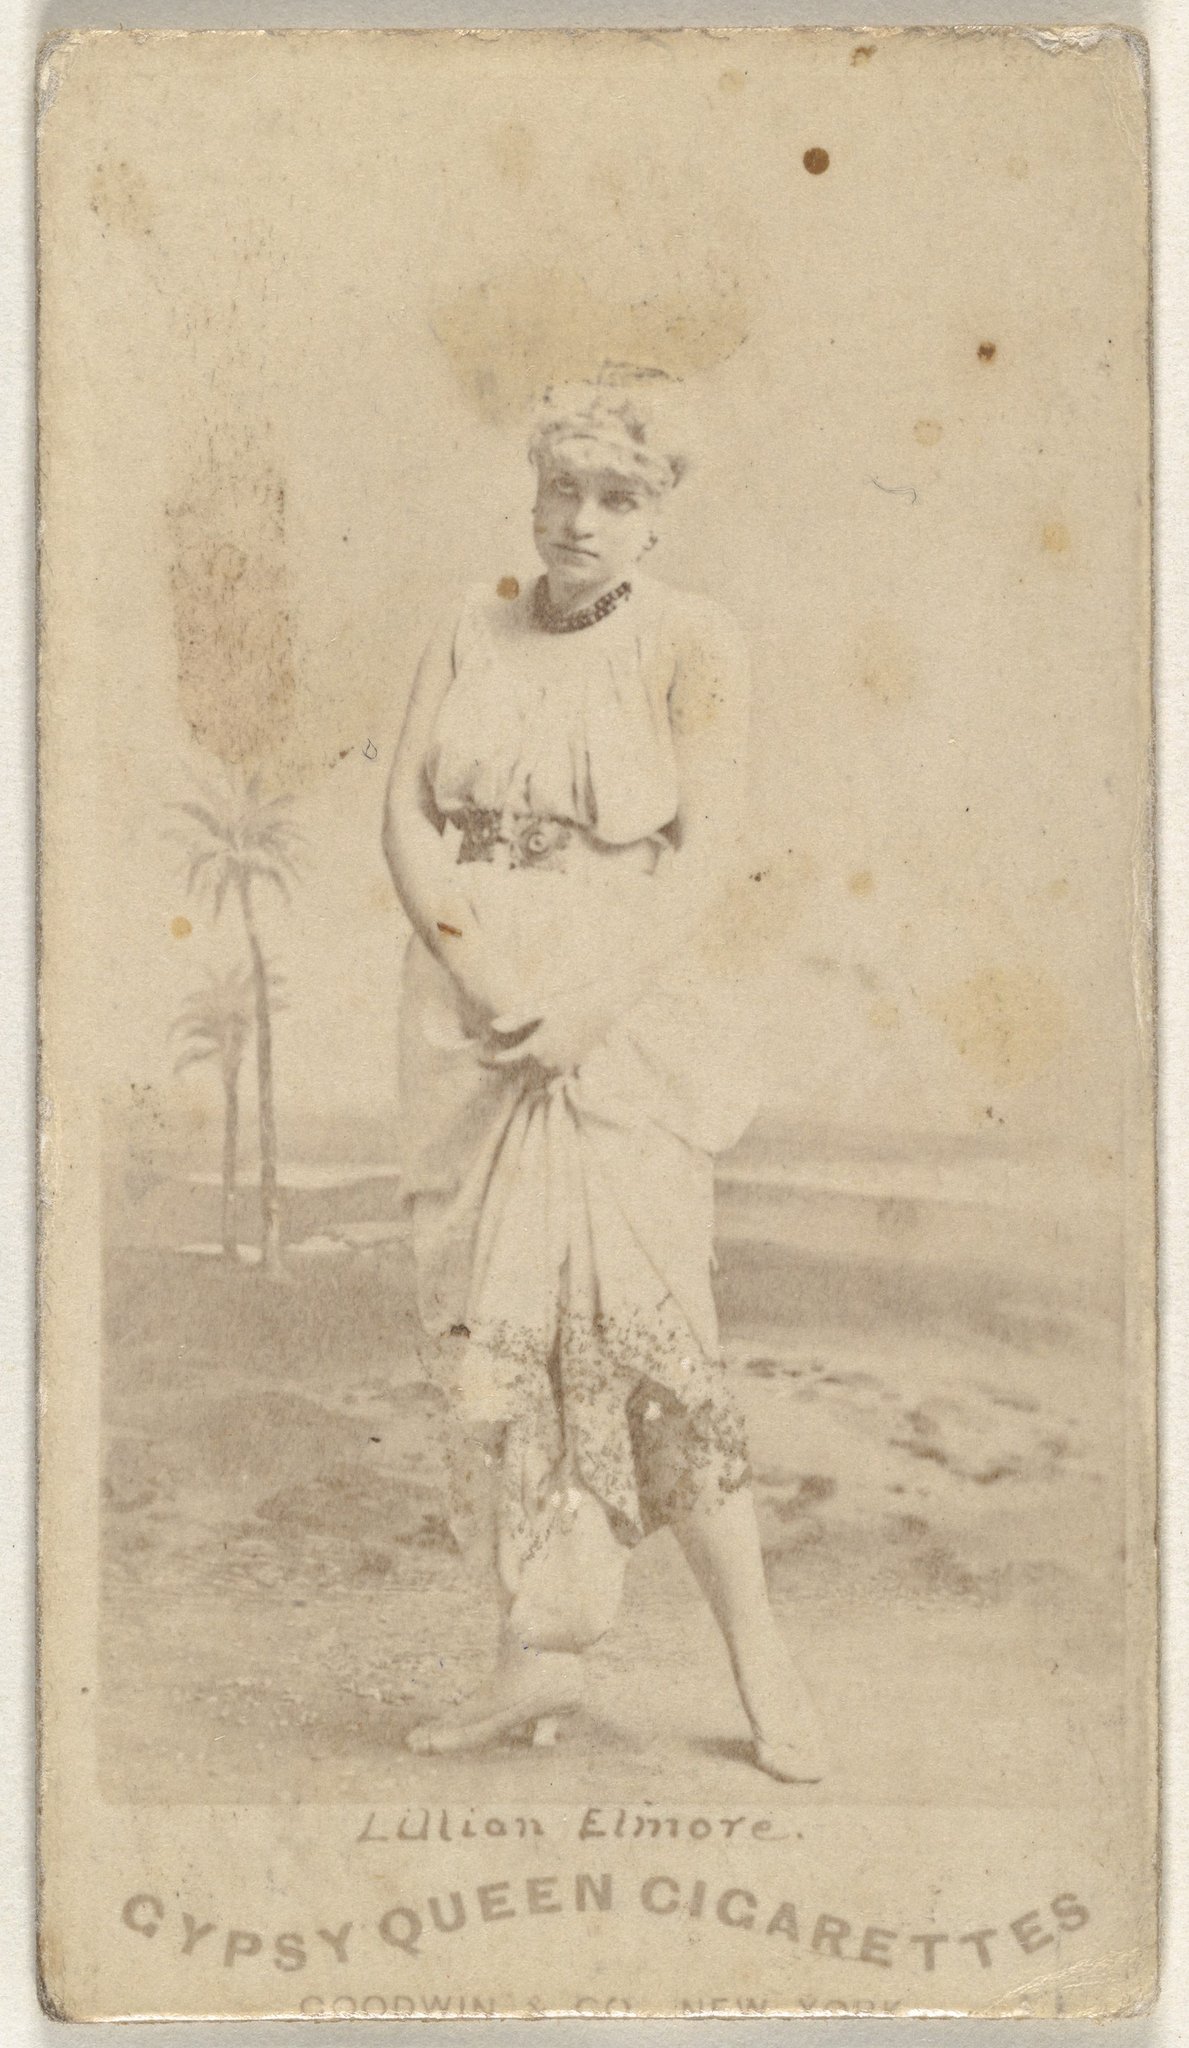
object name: photograph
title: Lillian Elmore, from the Actors and Actresses series (N171) for Gypsy Queen Cigarettes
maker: goodwin & company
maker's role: publisher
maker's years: 1850-1950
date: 1886-1890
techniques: albumen silver print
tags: portraits,women,actresses